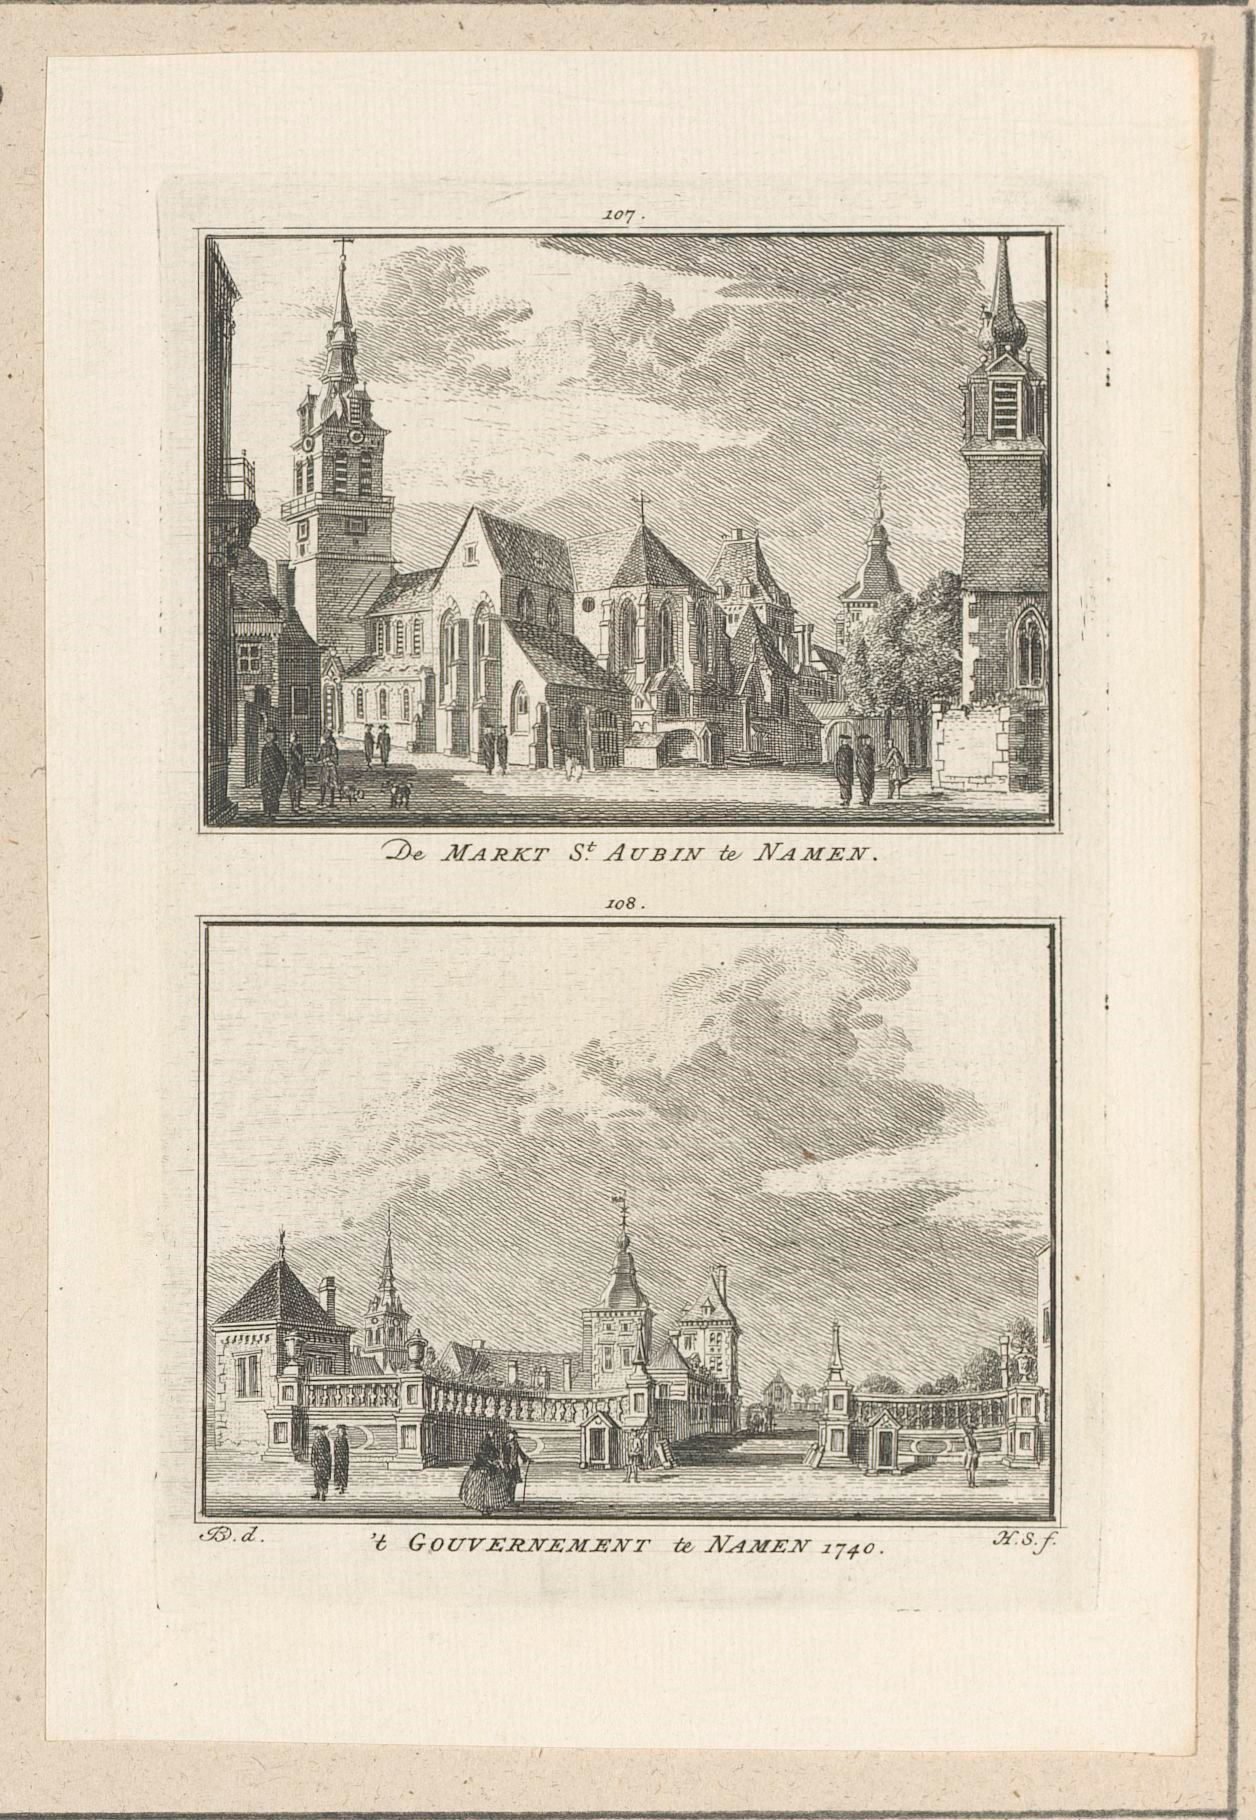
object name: print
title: Gezicht op de markt St. Aubin en een gezicht op het gouvernement, te Namen, 1740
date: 1746-1792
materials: paper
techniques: engraving, etching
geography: haarlem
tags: market, prospect of city, town panorama, silhouette of city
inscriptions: collector's mark: Lugt 2228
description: Prent ook gebruikt in: Het verheerlykt Nederland of kabinet van hedendaagsche gezigten van steden, dorpen (…). 9 delen. Amsterdam: Isaak Tirion en weduwe Isaak Tirion, 1745-1774, dl. 2 (1746), ill. 107-108. Of in: Nederlandsche tafereelen; of eene keurige verzameling van negen honderd fraaije gezigten van steden, dorpen, sloten, oudheden (…). 9 delen. Amsterdam: Jan de Groot, 1792, dl. 2, ill. 107-108.